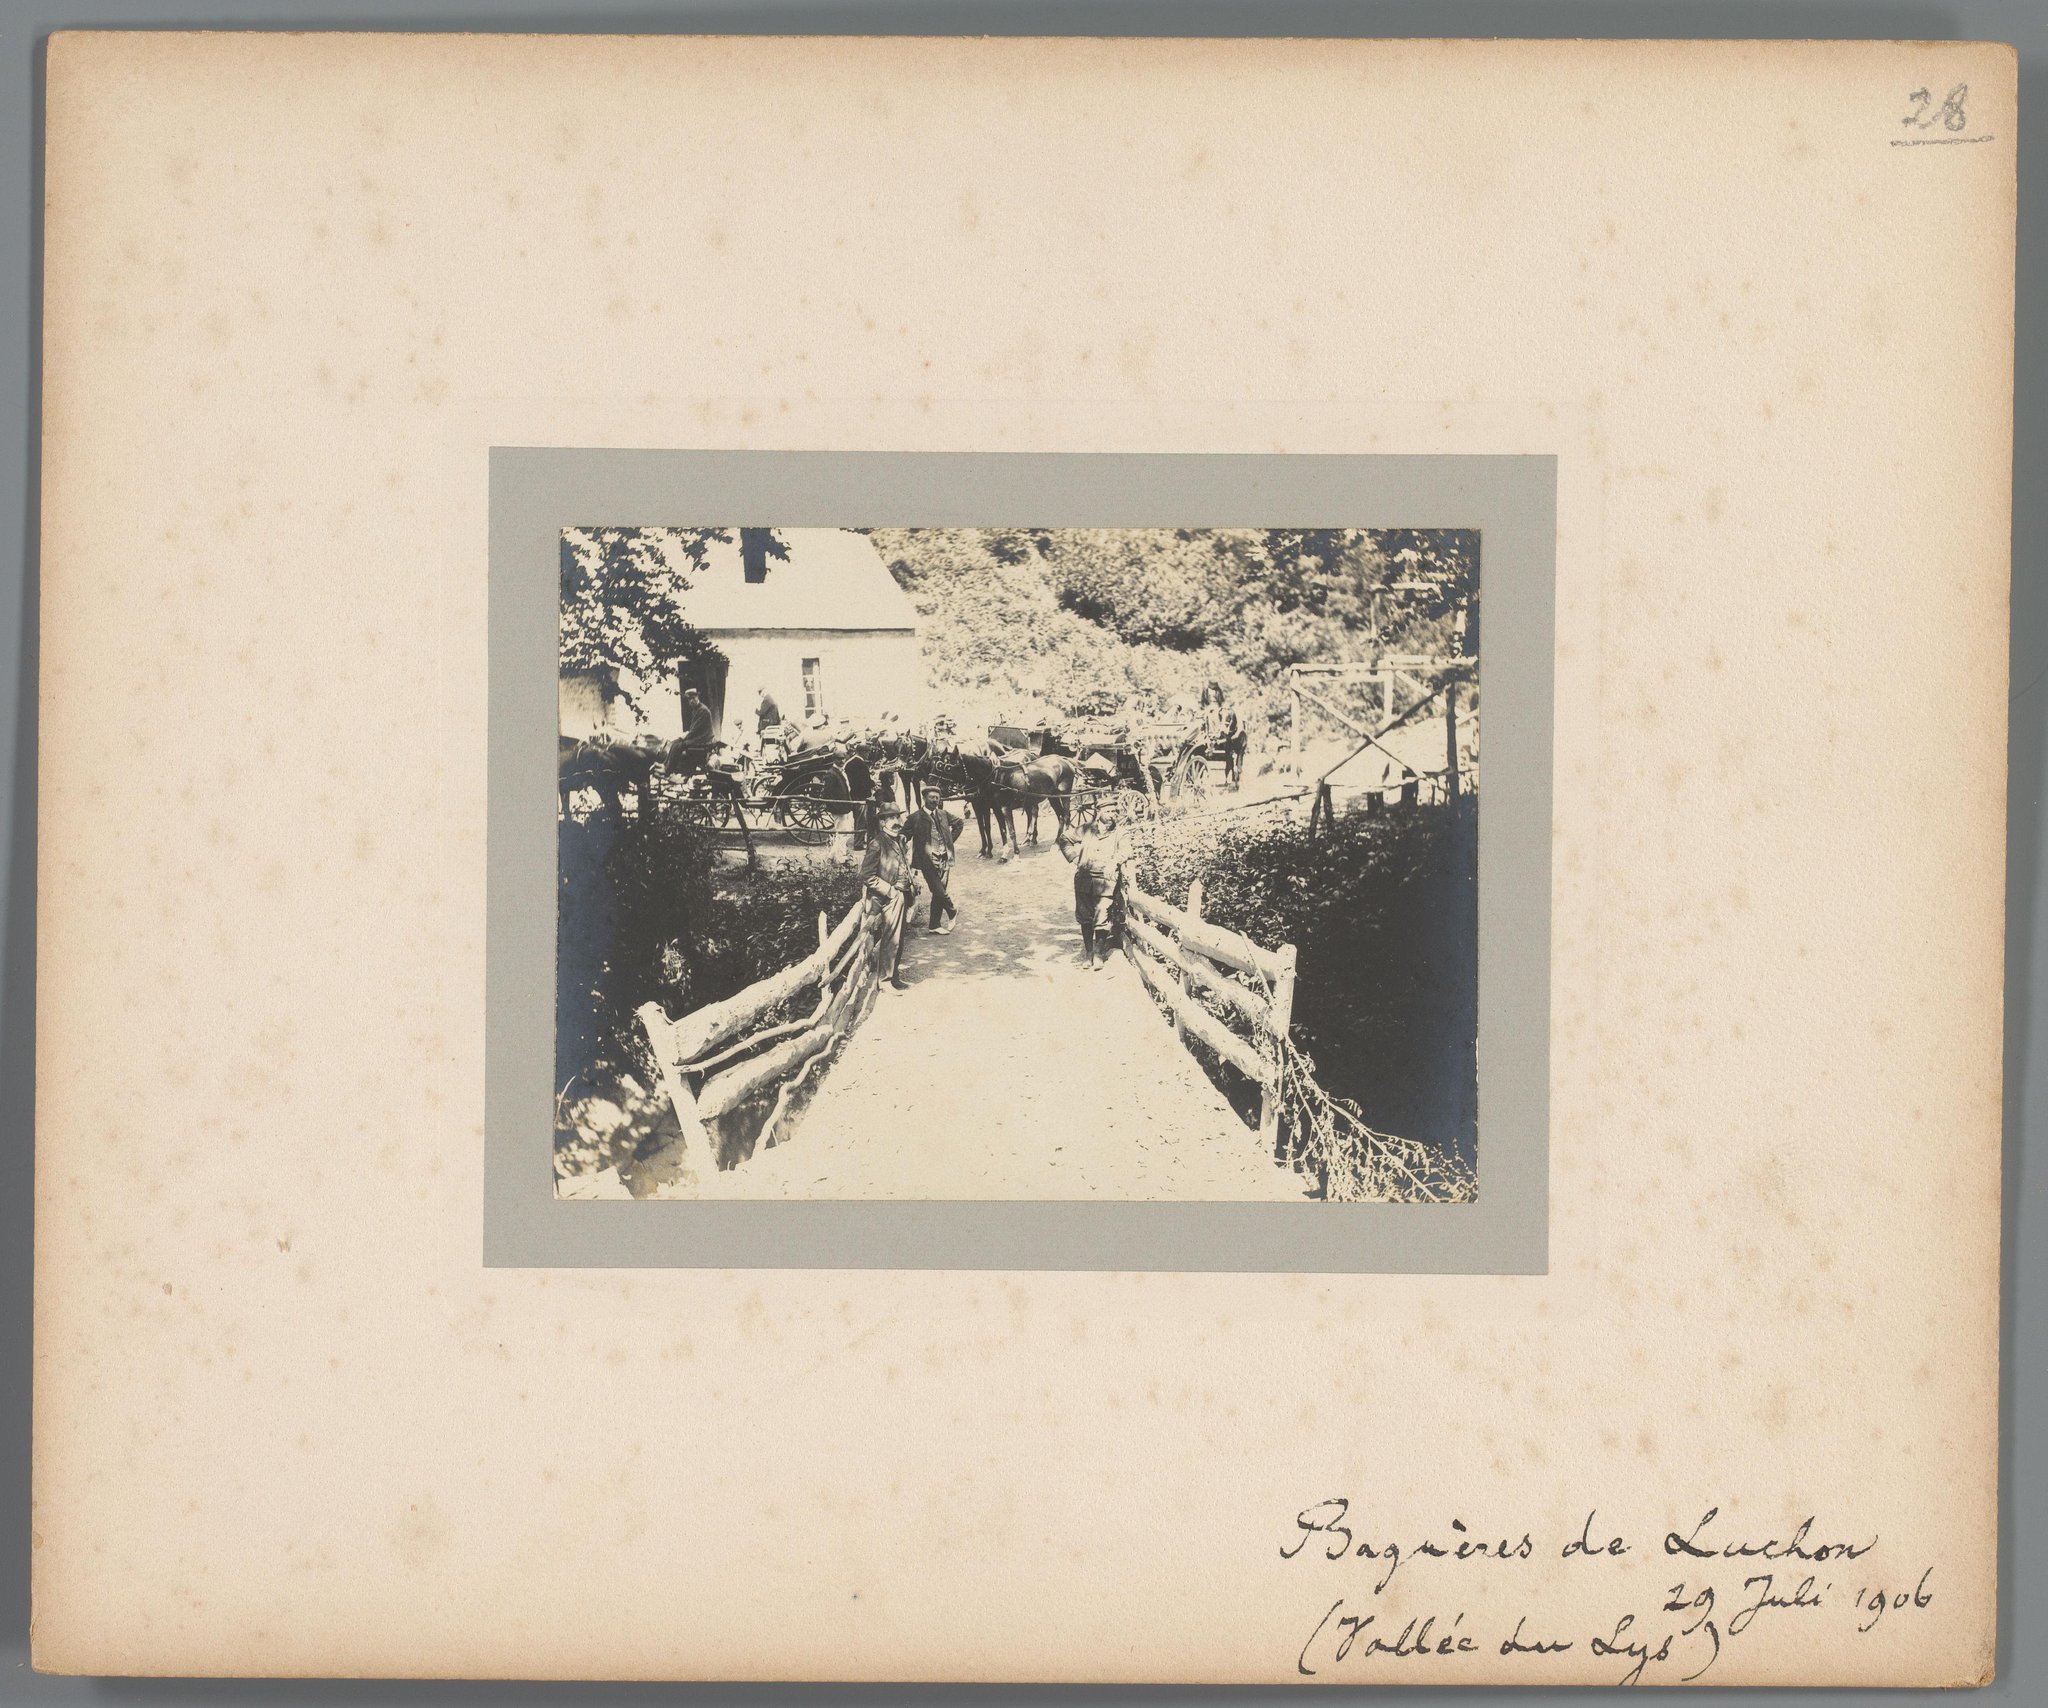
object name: photograph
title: Drie mannen op een brug in de Vallée du Lys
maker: françois buys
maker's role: advocaat, amateurfotograaf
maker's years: 1871-1934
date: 1906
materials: paper, cardboard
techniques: gelatin silver print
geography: bagnères-de-luchon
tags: bridge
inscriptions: number: ‘28’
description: Deze foto maakt deel uit van een groep van 49 foto's.